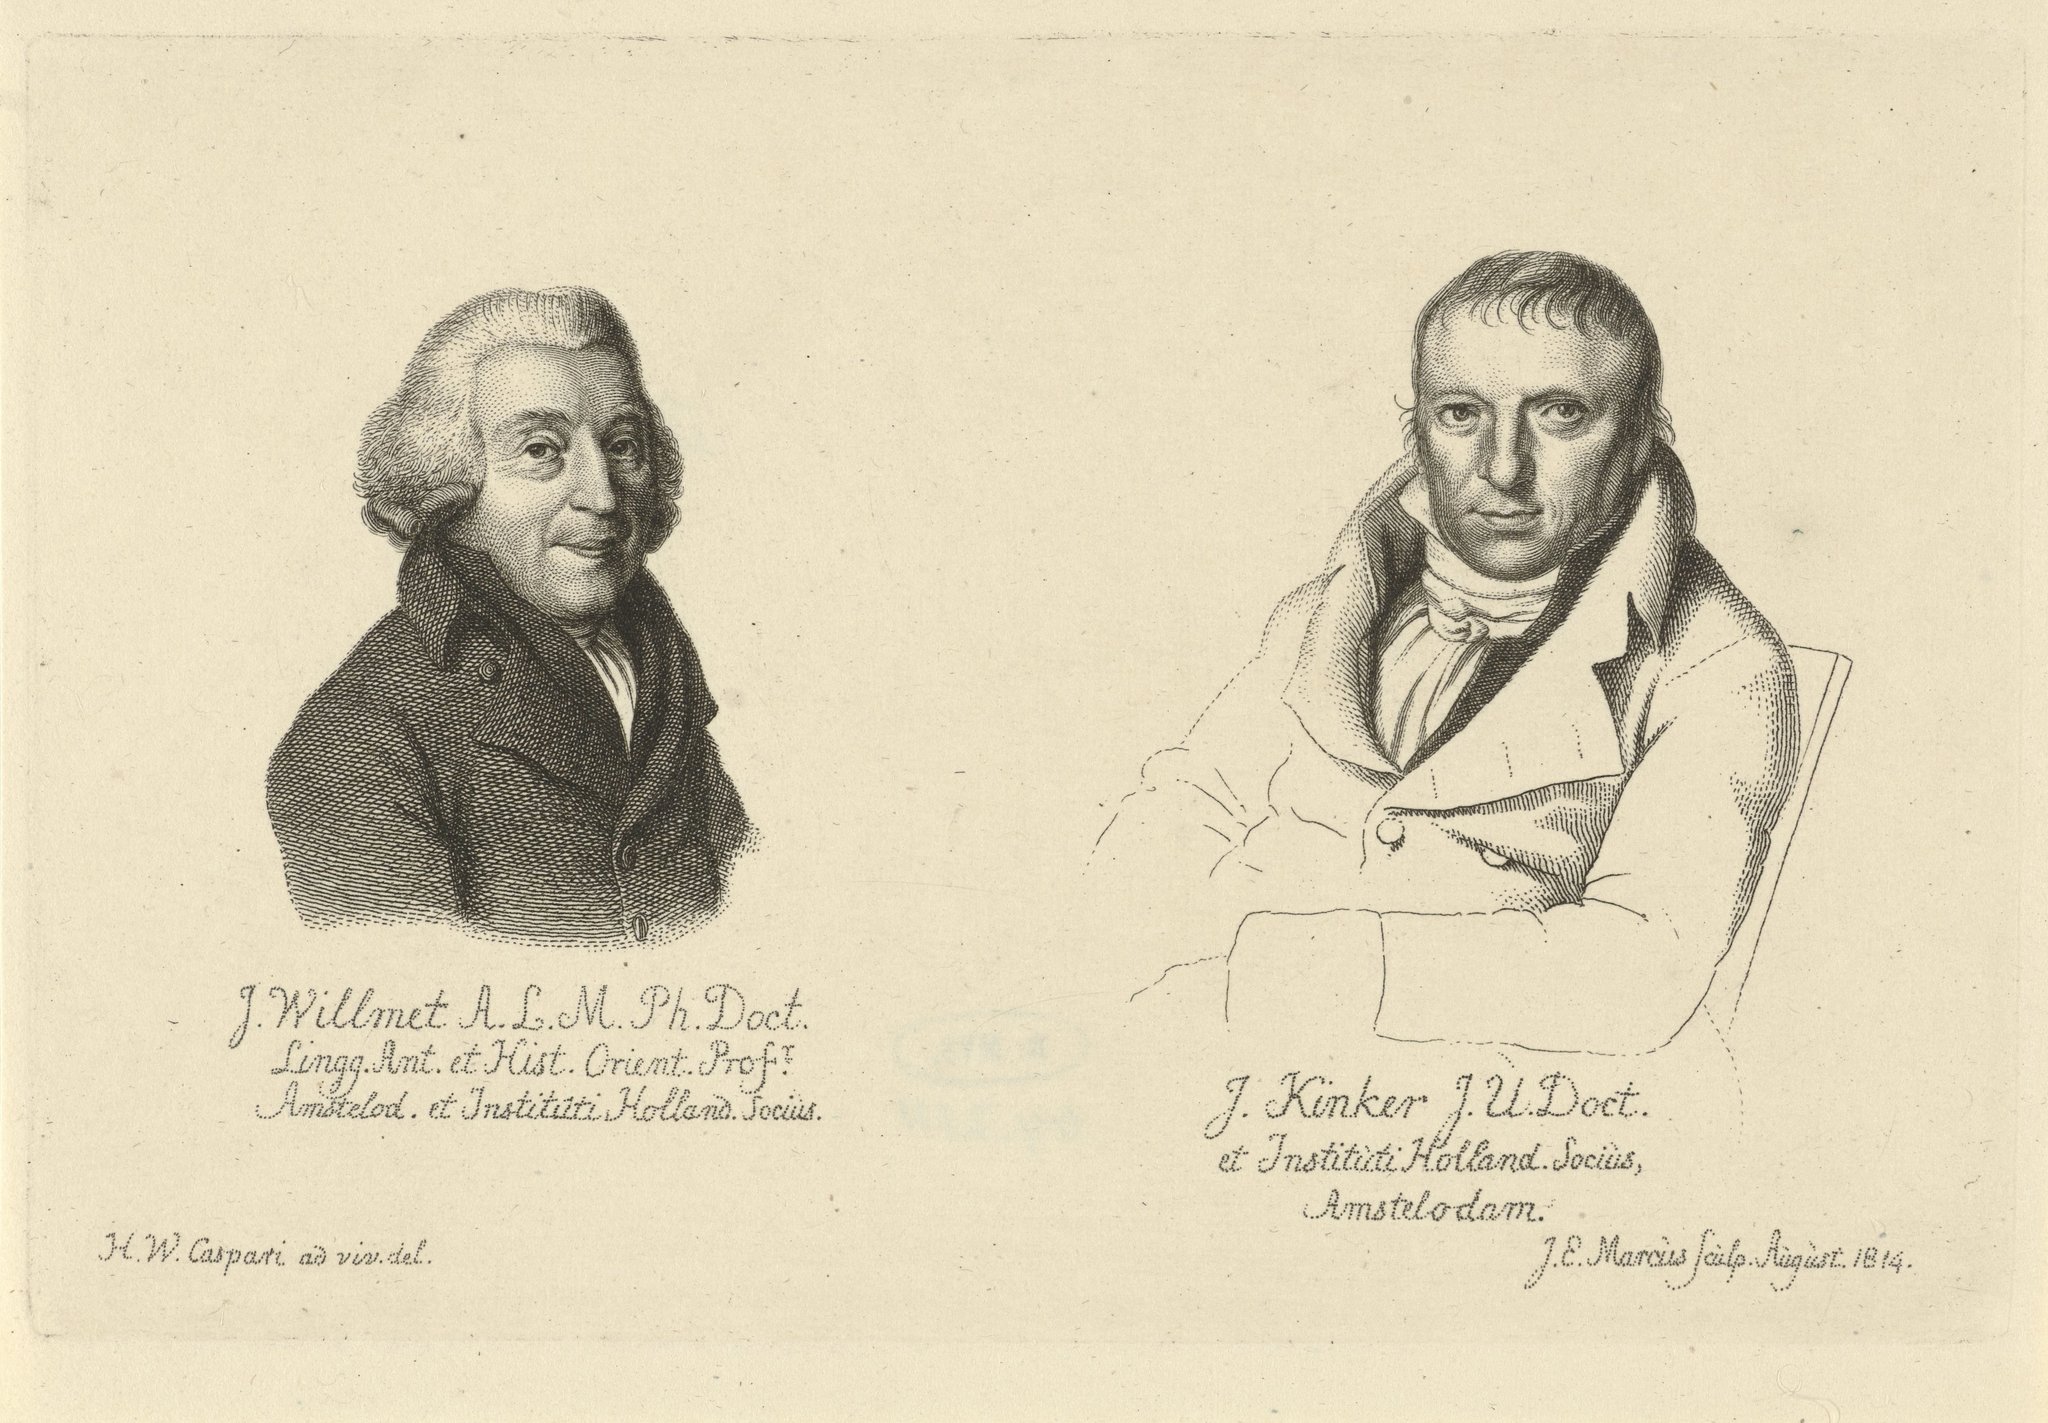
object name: print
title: Portretten van Joannes Wilmet en Johannes Kinker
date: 1808-1814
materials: paper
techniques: etching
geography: amsterdam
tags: johannes kinker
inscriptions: collector's mark: Lugt 2228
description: Serie voor het eerst uitgegeven door Jacob Ernst Marcus onder de titel Studiebeelden en Fragmenten. Amsterdam: ca.1816. Later heruitgegeven als: Studie-prentwerk/ Etudes gravées.